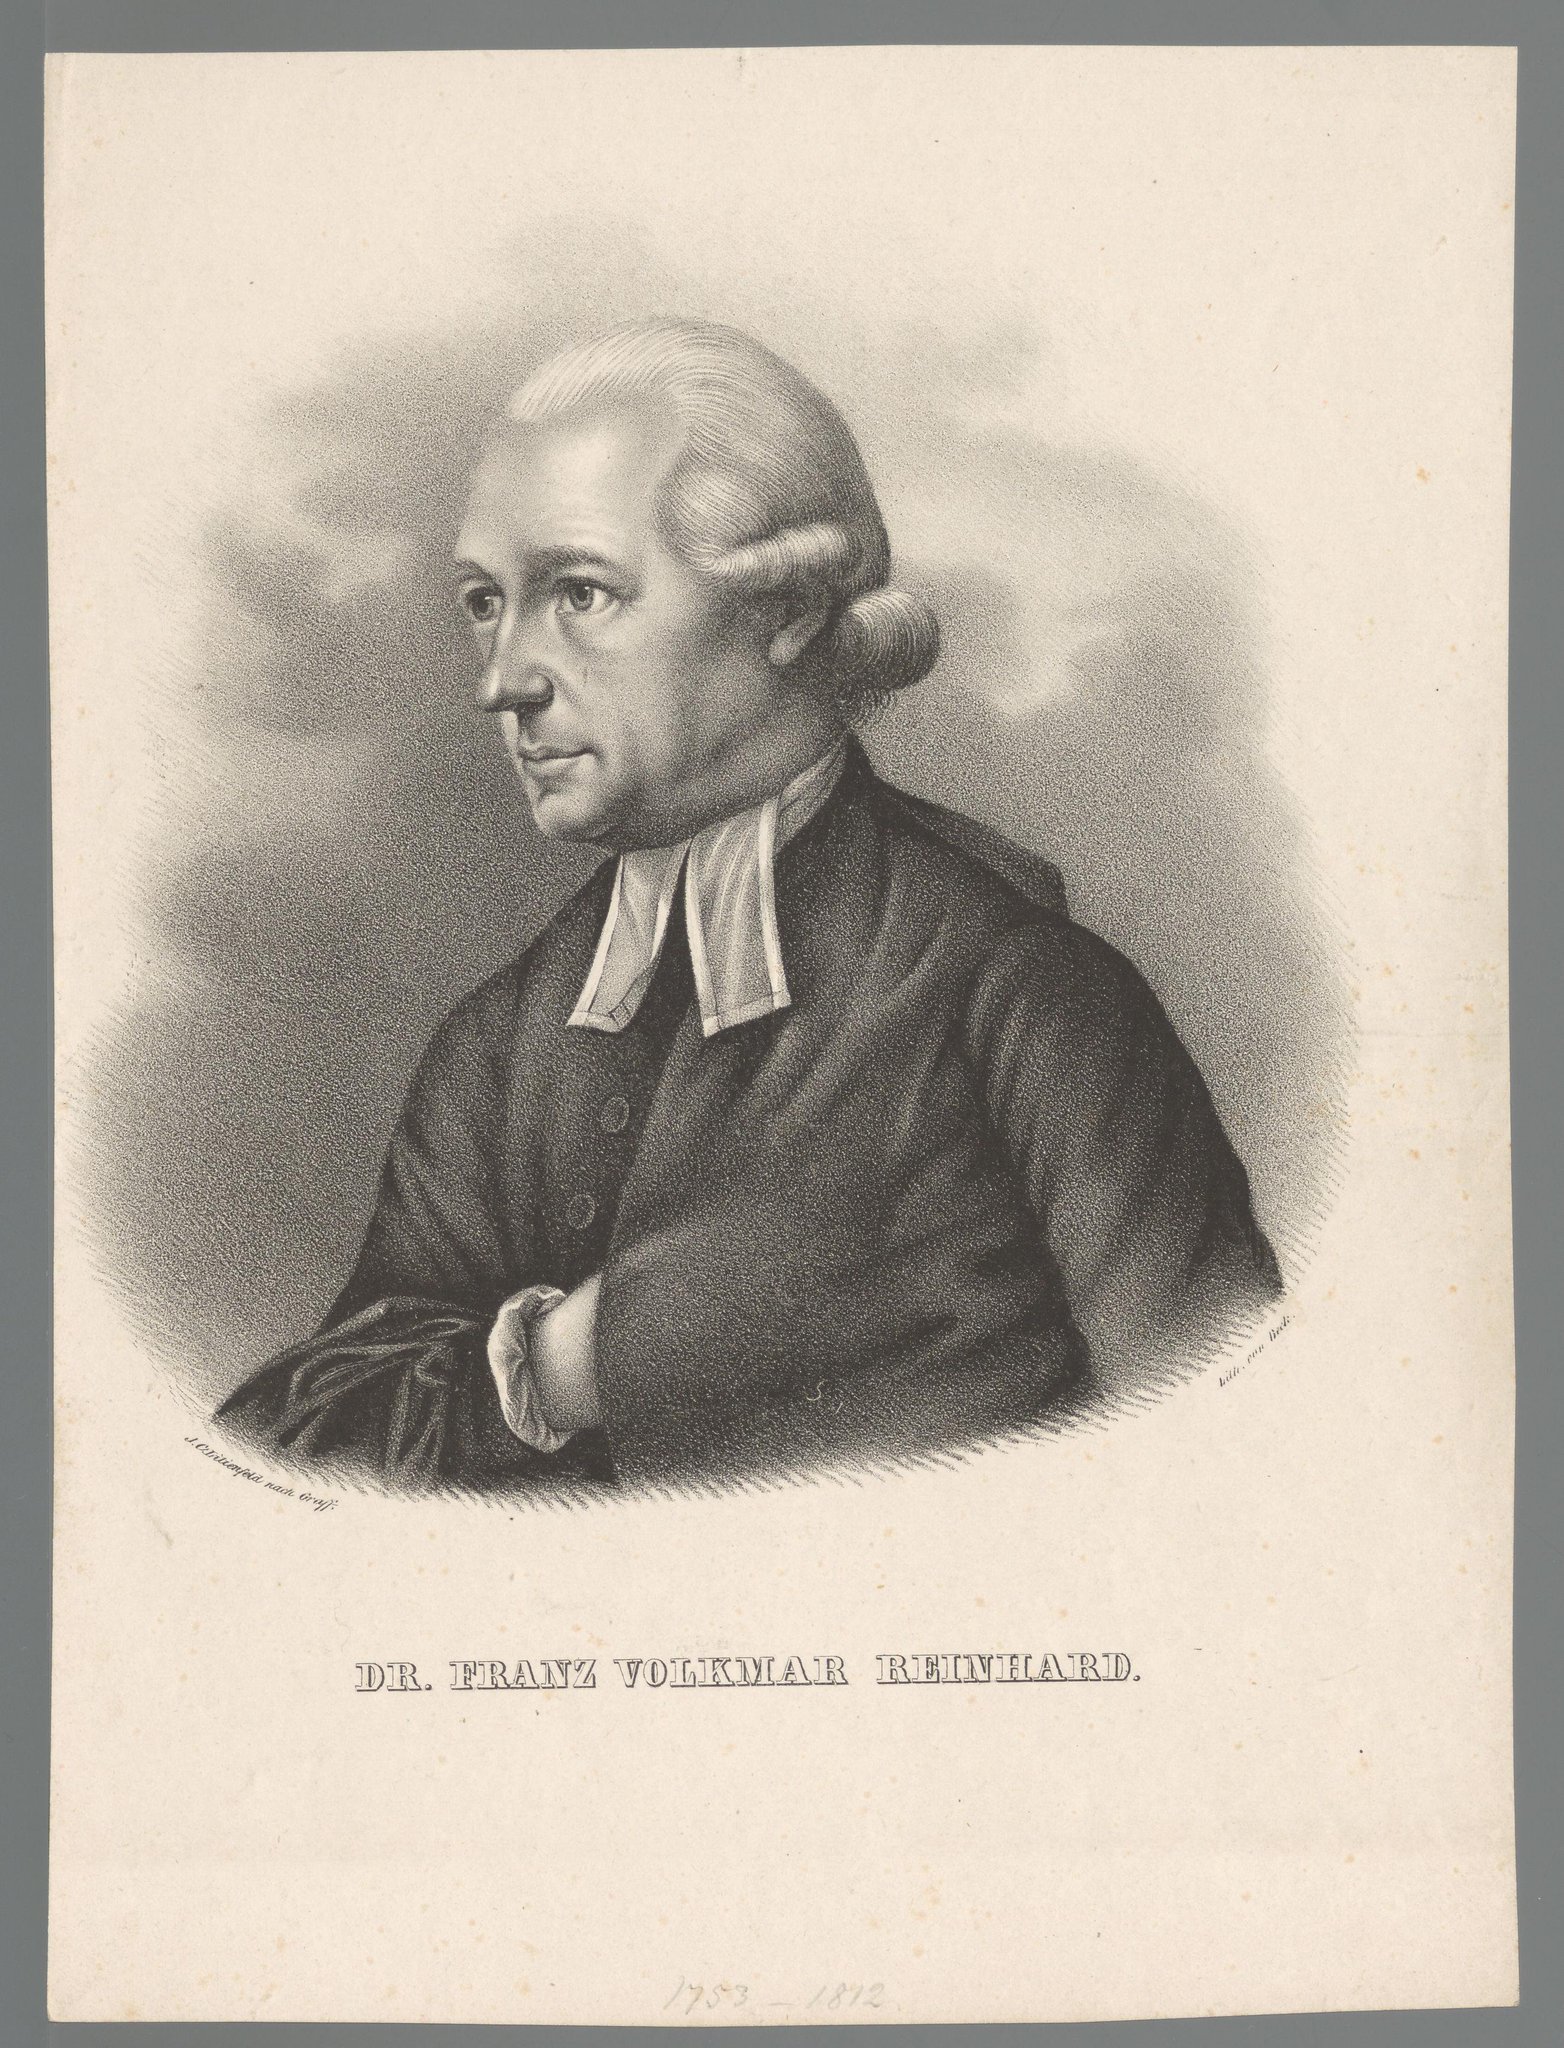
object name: print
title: Dr. Franz Volkmar Reinhard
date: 1820-1860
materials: paper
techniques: lithograph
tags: theologian, historical persons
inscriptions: collector's mark: Lugt 2228